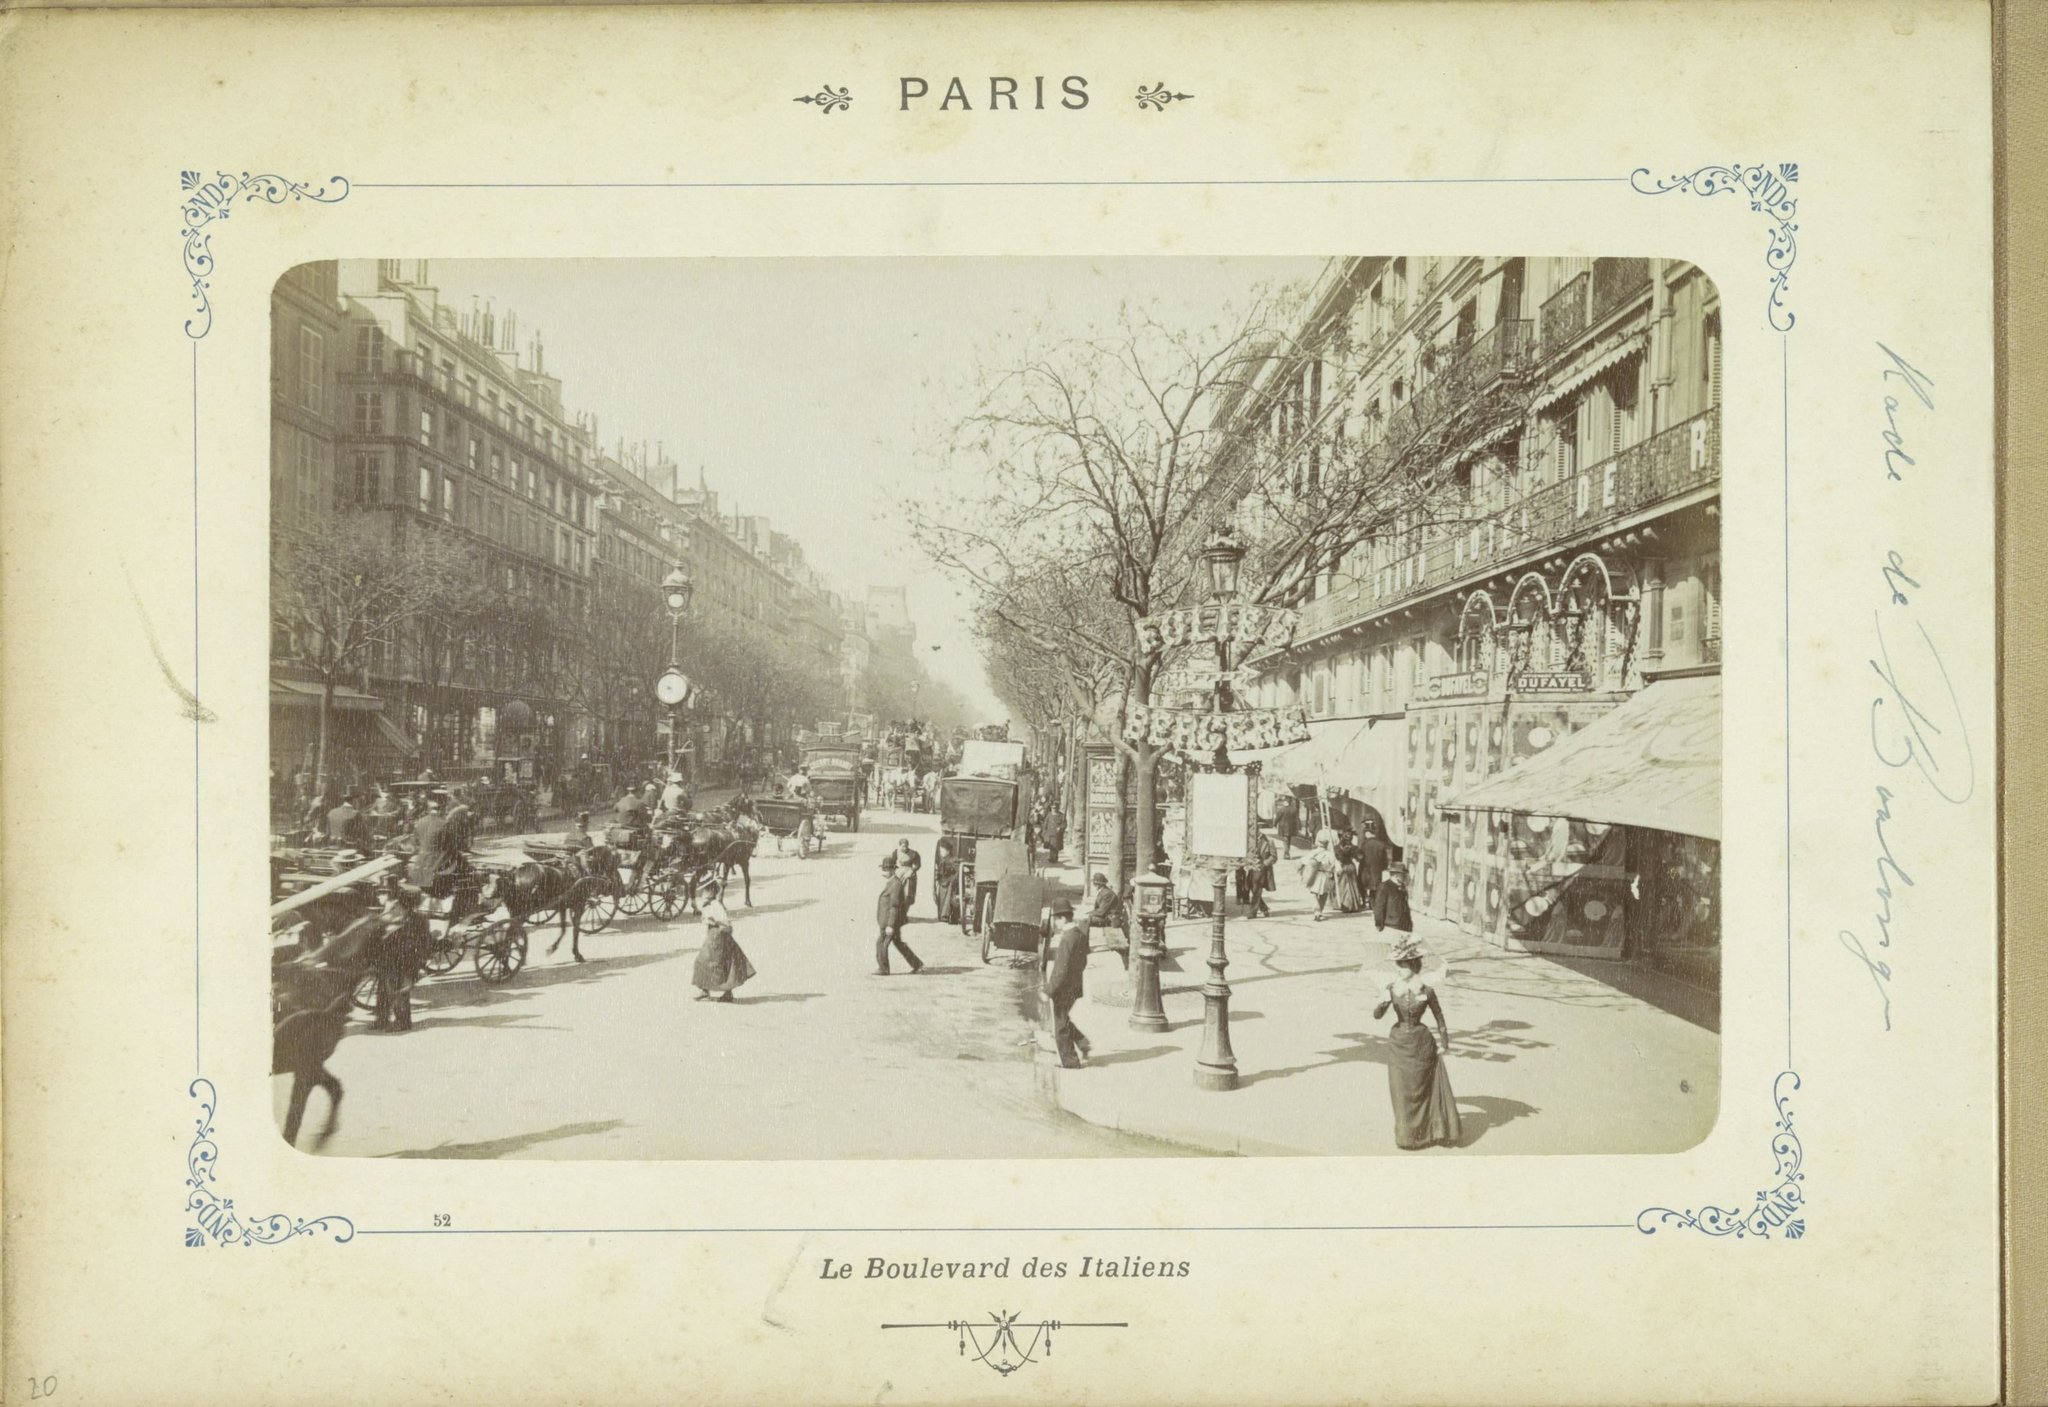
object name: photograph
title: Paris - Le Boulevard des Italiens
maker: Anonymous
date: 1900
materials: cardboard, paper, photographic support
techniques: albumen print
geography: paris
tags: avenue, boulevard, promenade, esplanade (+ city(-scape) with figures, staffage), paris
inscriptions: inscription: ‘Kade de Boulanger’, number: ‘52’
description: Onderdeel van Fotoalbum met bezienswaardigheden in Parijs, Versailles en het Bois de Boulogne.